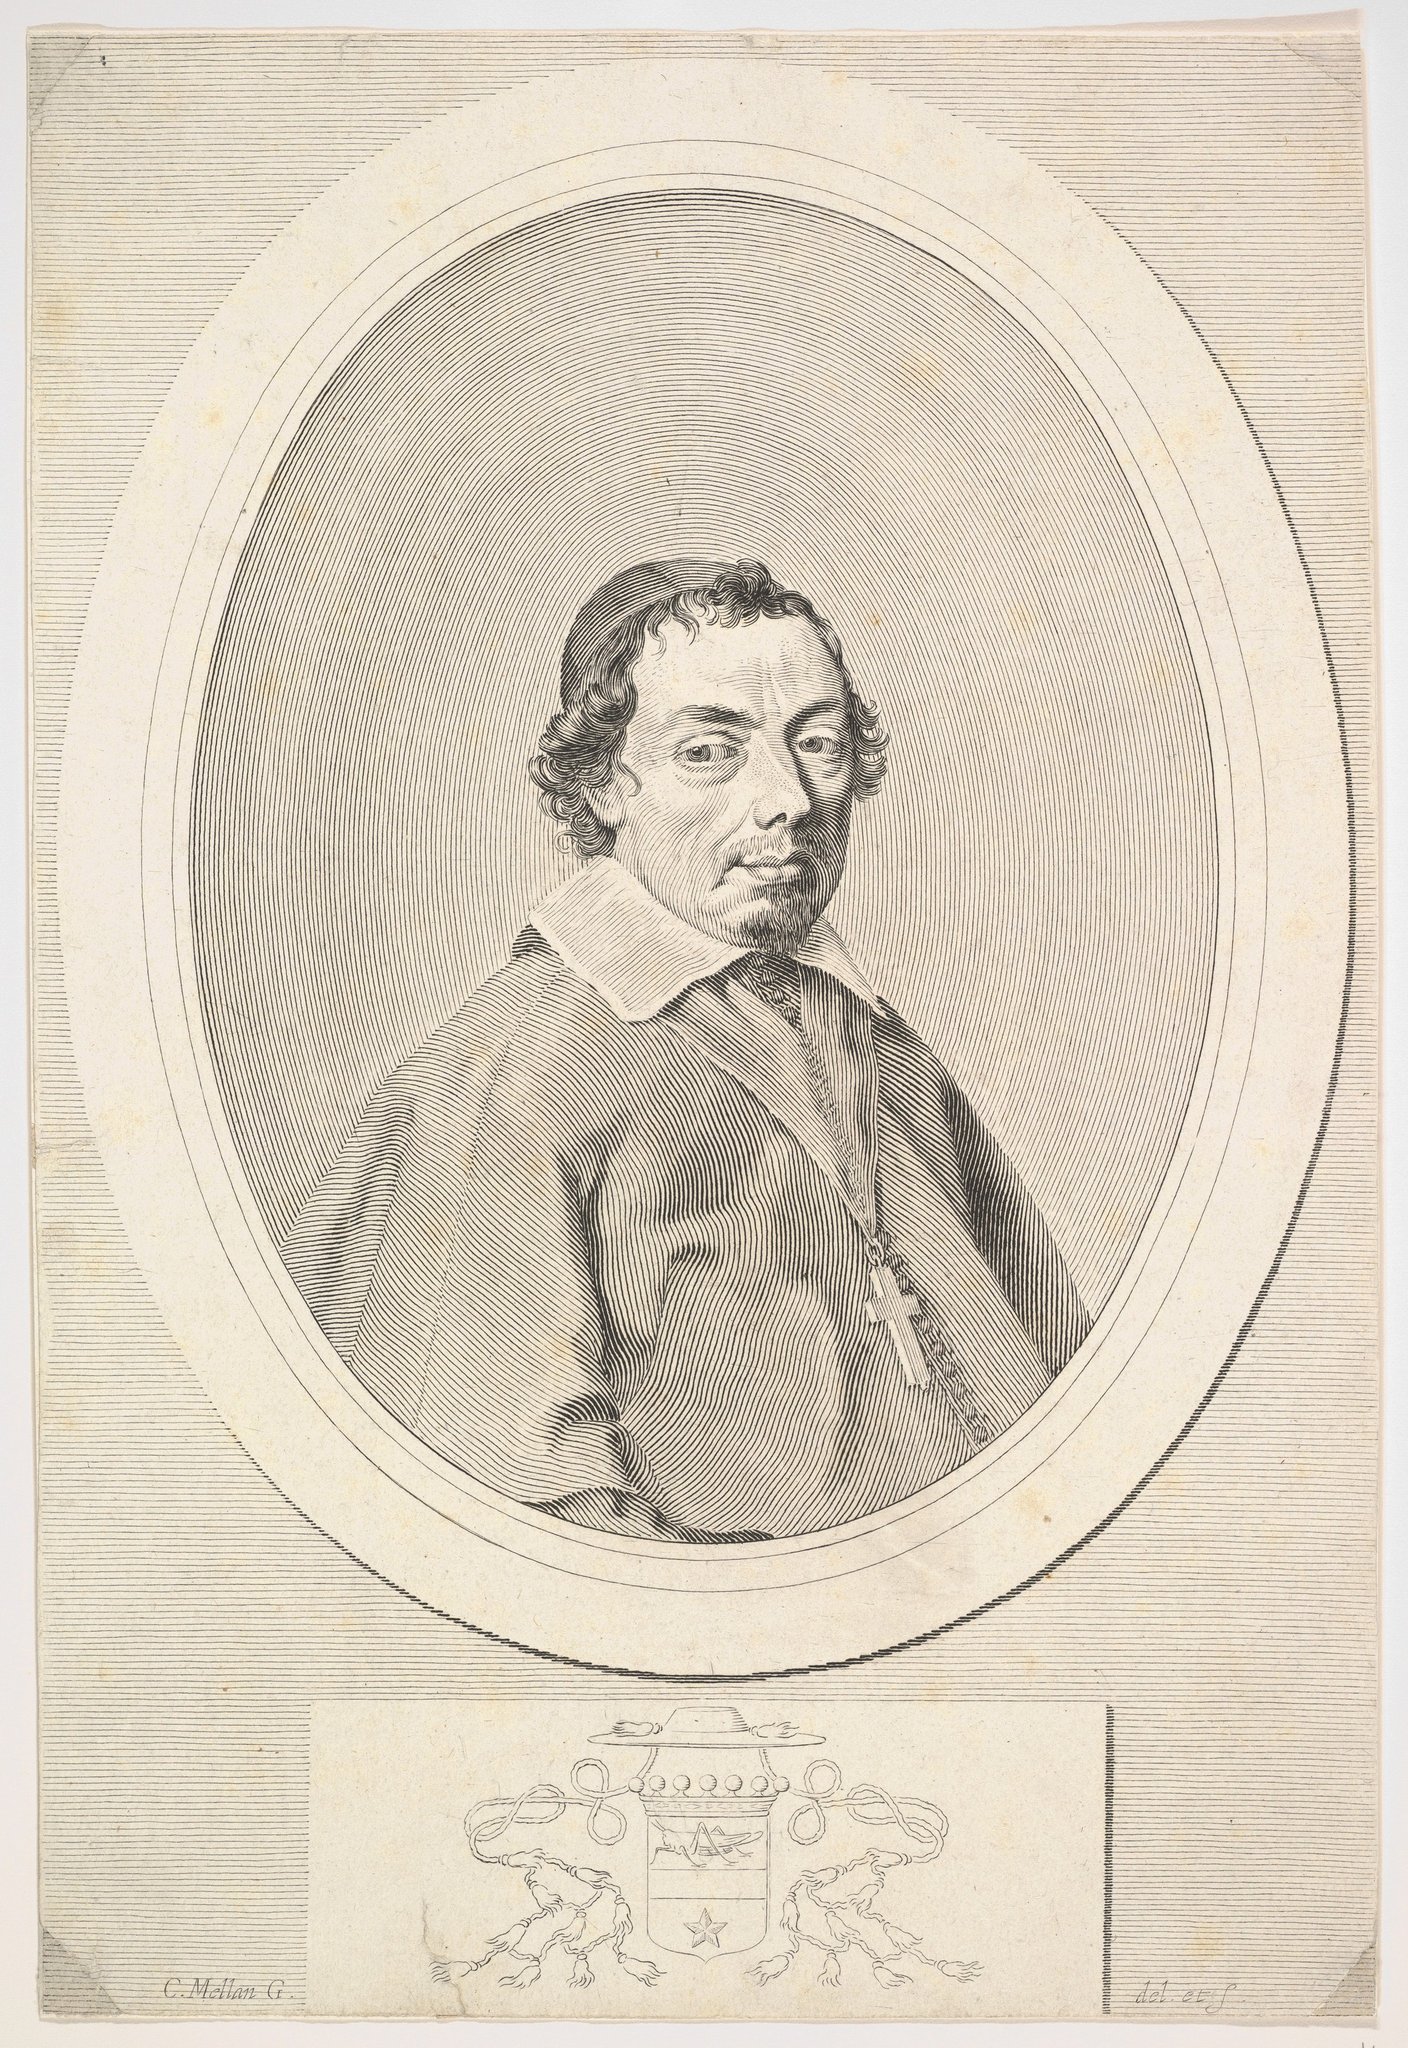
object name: print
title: Nicolas Grillié, Bishop of Uzès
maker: claude mellan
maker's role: artist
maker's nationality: french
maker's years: 1598-1688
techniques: engraving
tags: men,portraits,bishops,coat of arms